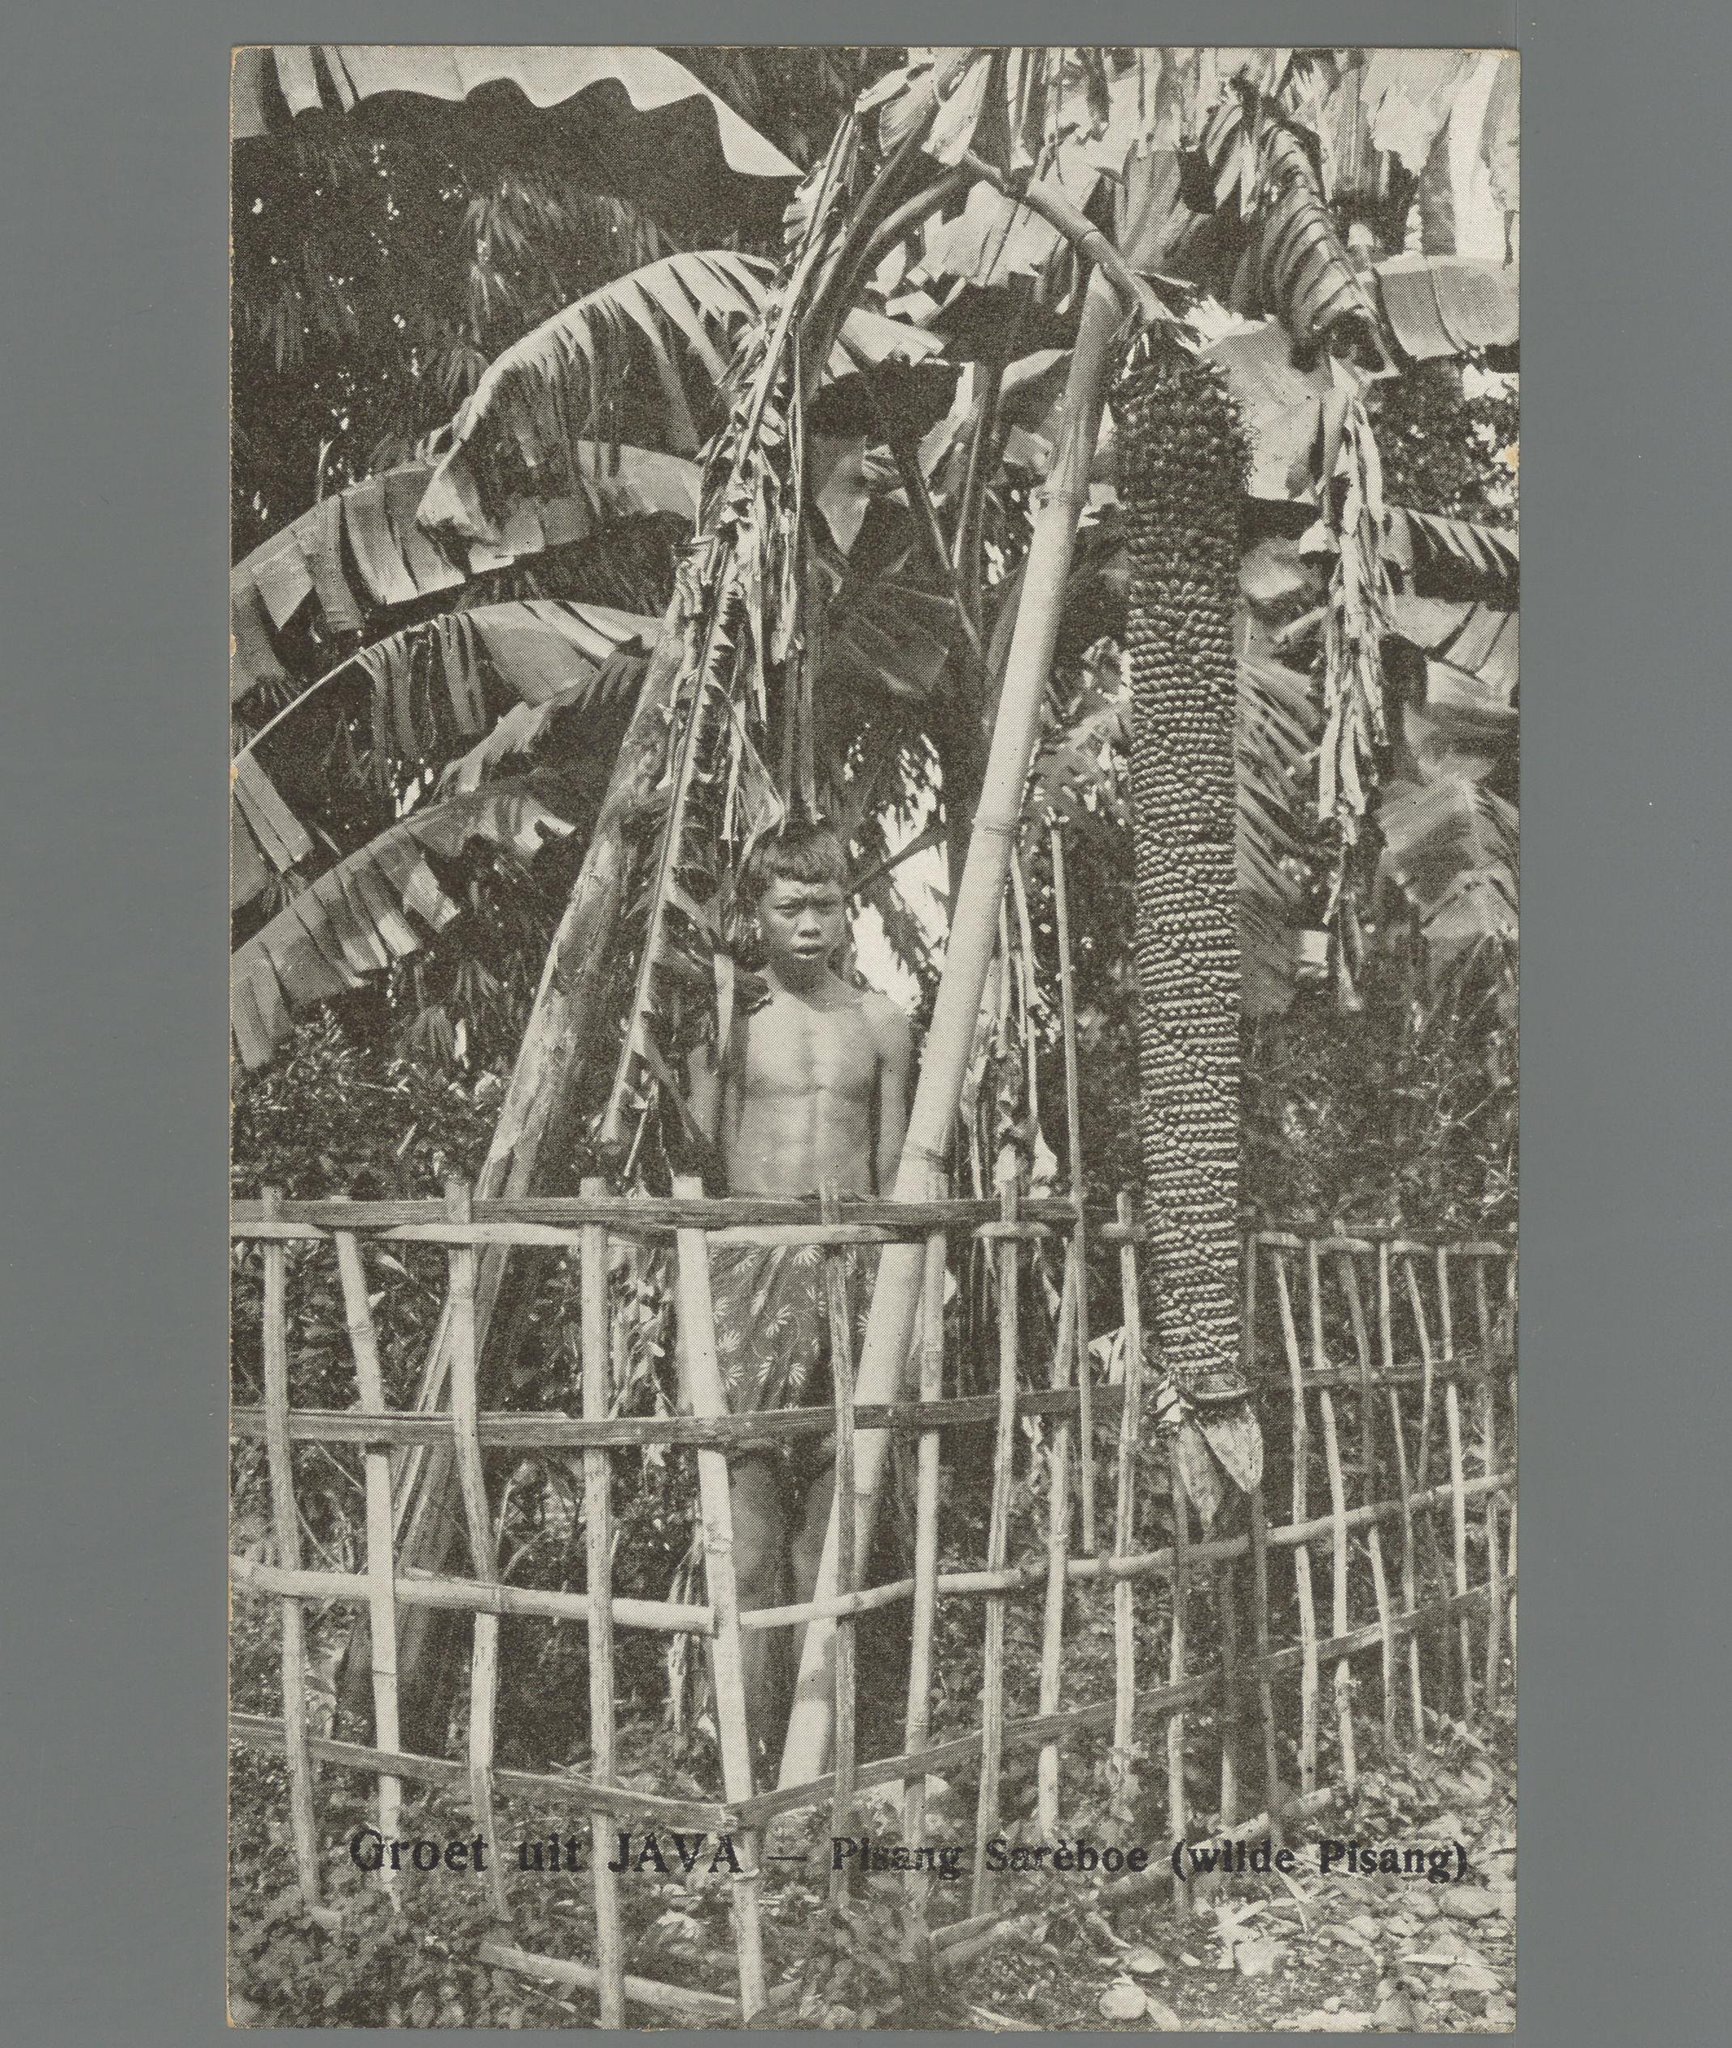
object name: ansichtkaart, prentbriefkaart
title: Groet uit Java - Pisang Sarèboe (wilde pisang)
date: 1906-1930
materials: cardboard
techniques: autotype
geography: weltevreden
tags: trees, fruits: banana, java